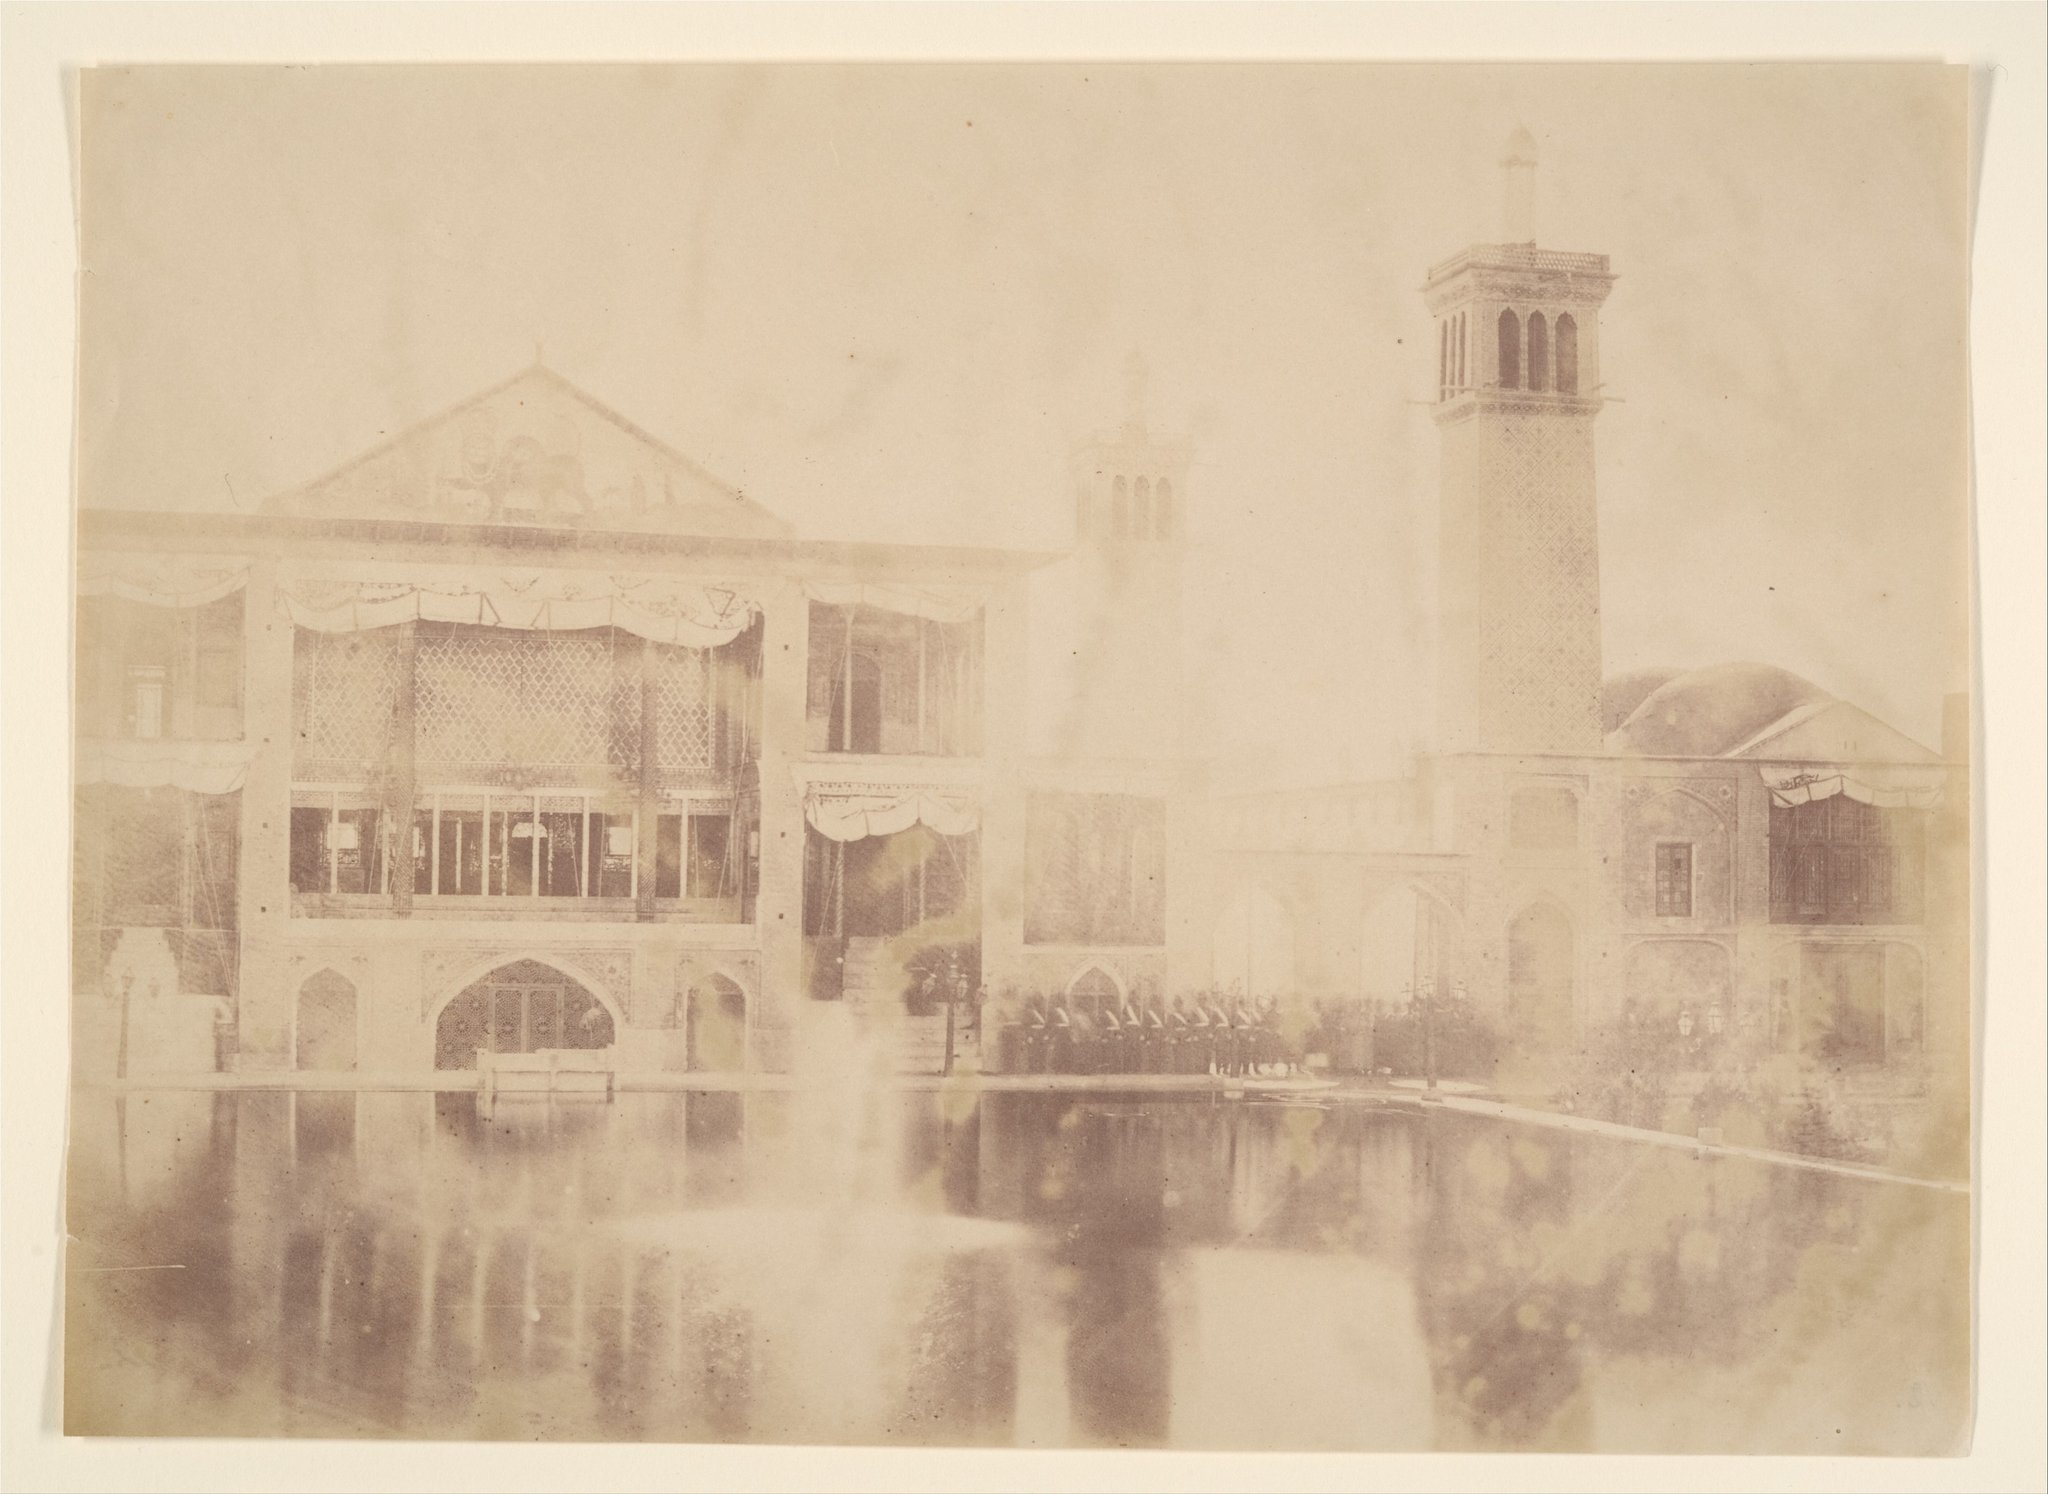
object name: photograph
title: [Palace of the Shah, Teheran, Iran]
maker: luigi pesce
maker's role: artist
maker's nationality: italian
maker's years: 1818-1891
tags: architecture,palaces